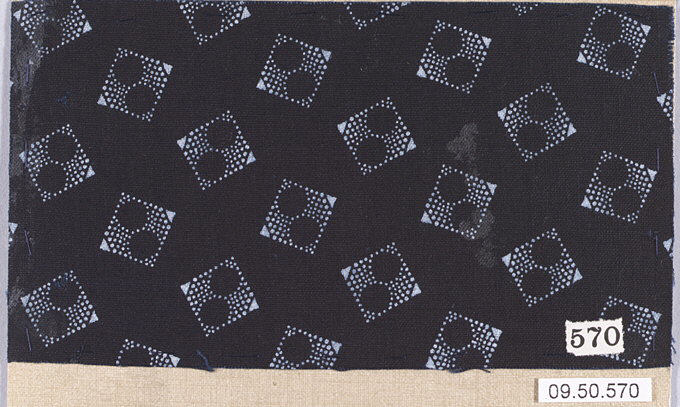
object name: piece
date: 1801-1900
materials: cotton